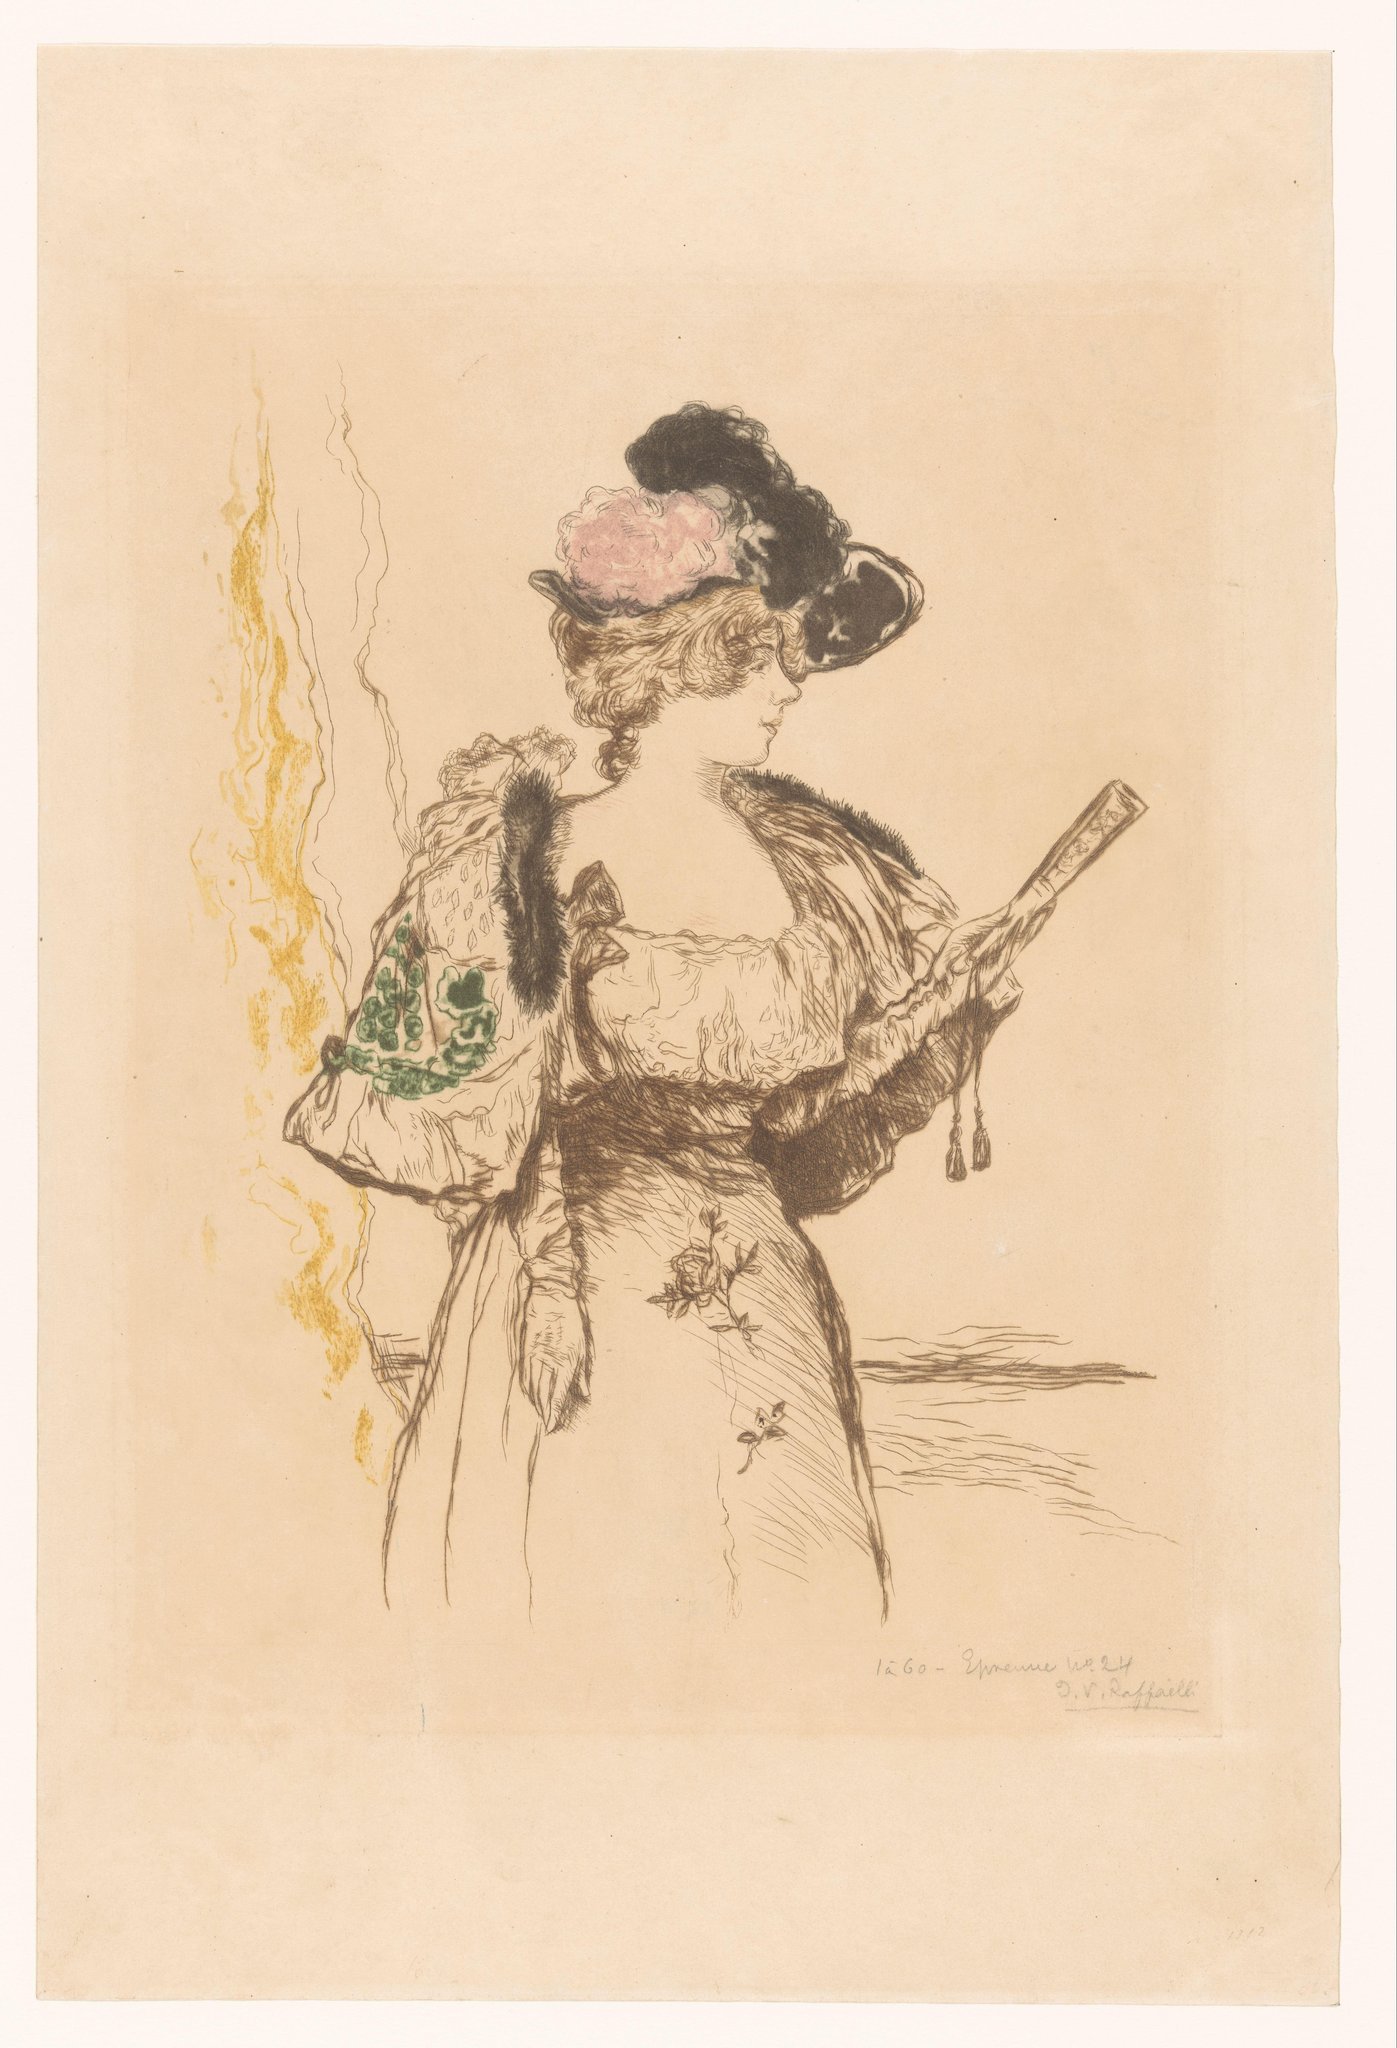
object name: print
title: L'Actrice en scène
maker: jean françois raffaëlli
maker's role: print maker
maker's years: 1850-1924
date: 1898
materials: paper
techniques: aquatint, drypoint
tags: adult woman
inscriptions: collector's mark: Lugt 2228, collector's mark: Lugt 2760